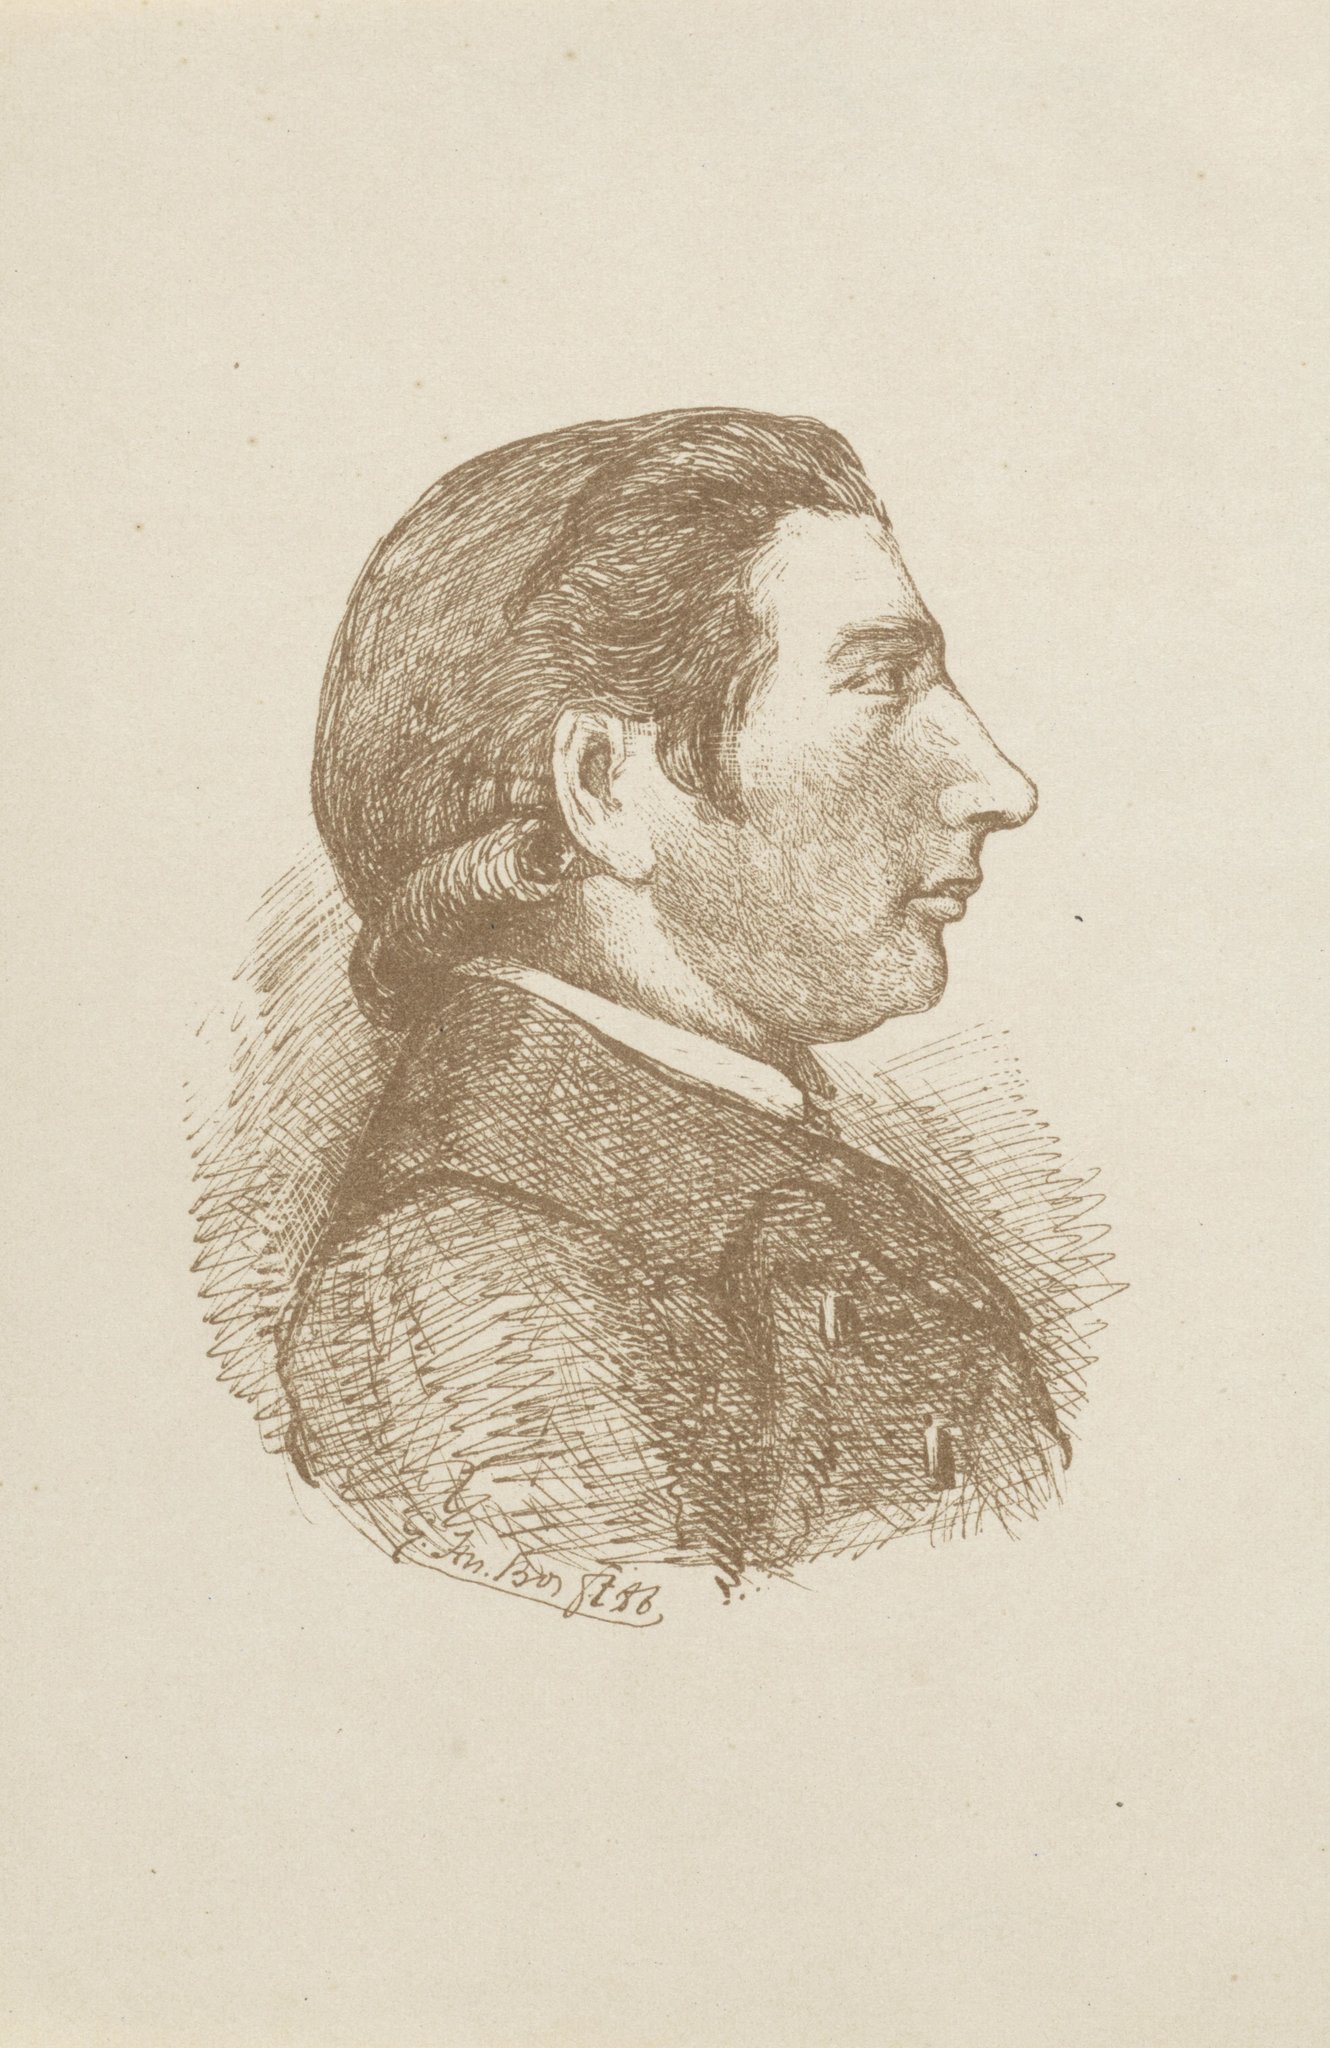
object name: print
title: Portret van Jacobus Bellamy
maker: pieter van loon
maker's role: draughtsman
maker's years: 1801-1873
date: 1886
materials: paper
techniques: printing, lithograph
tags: flushing, historical persons